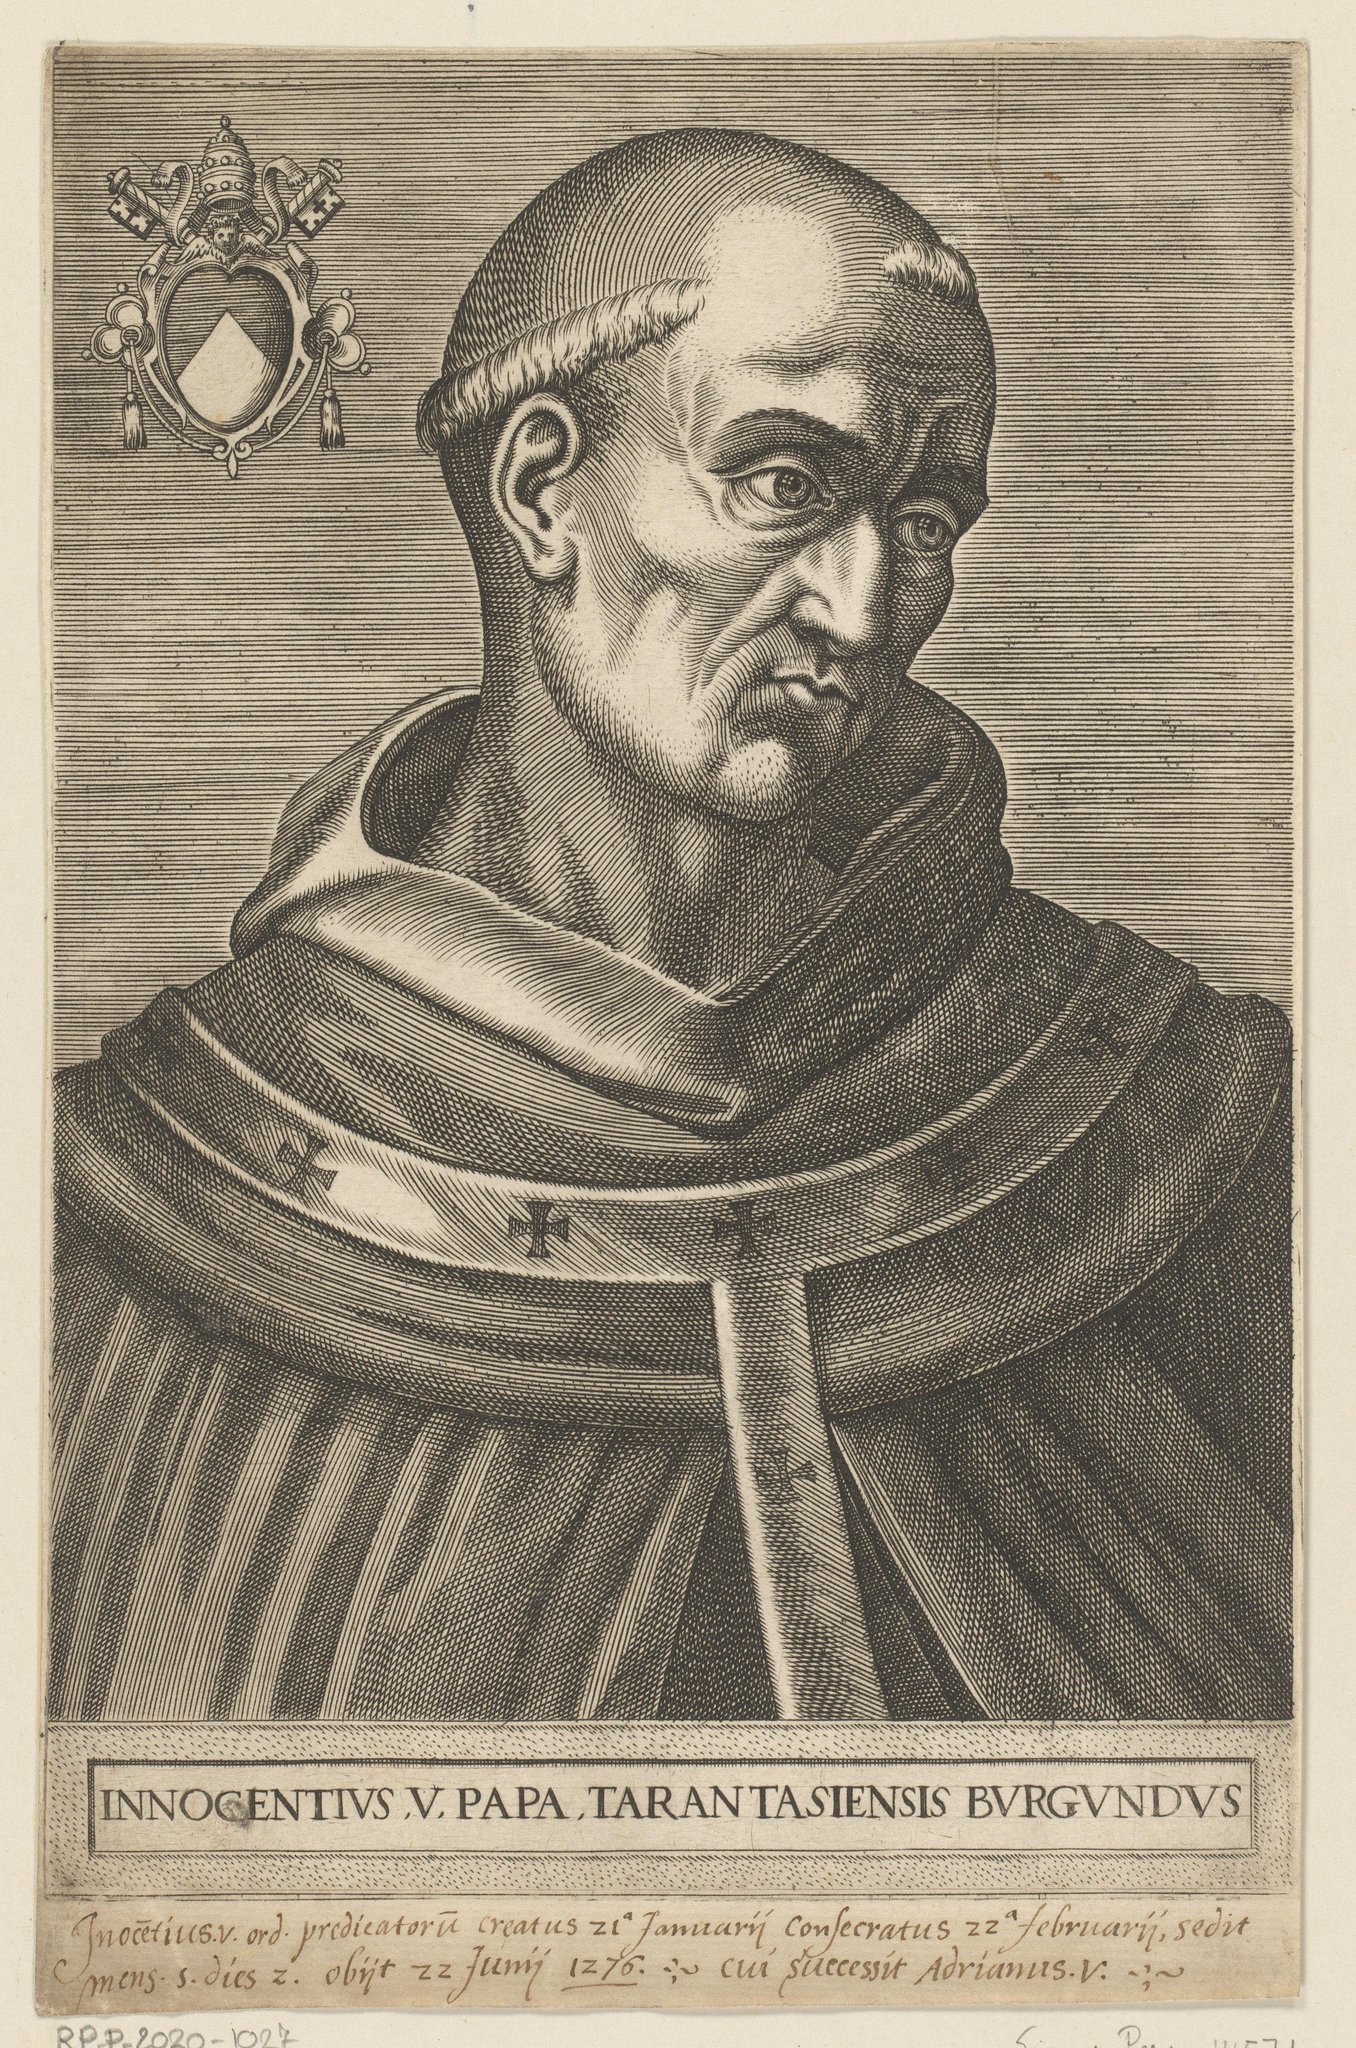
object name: print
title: Portret van paus Innocentius V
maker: Anonymous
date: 1550-1599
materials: paper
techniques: engraving, pen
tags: rome, historical persons, pope, armorial bearing, heraldry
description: Met links naast het hoofd zijn wapenschild.